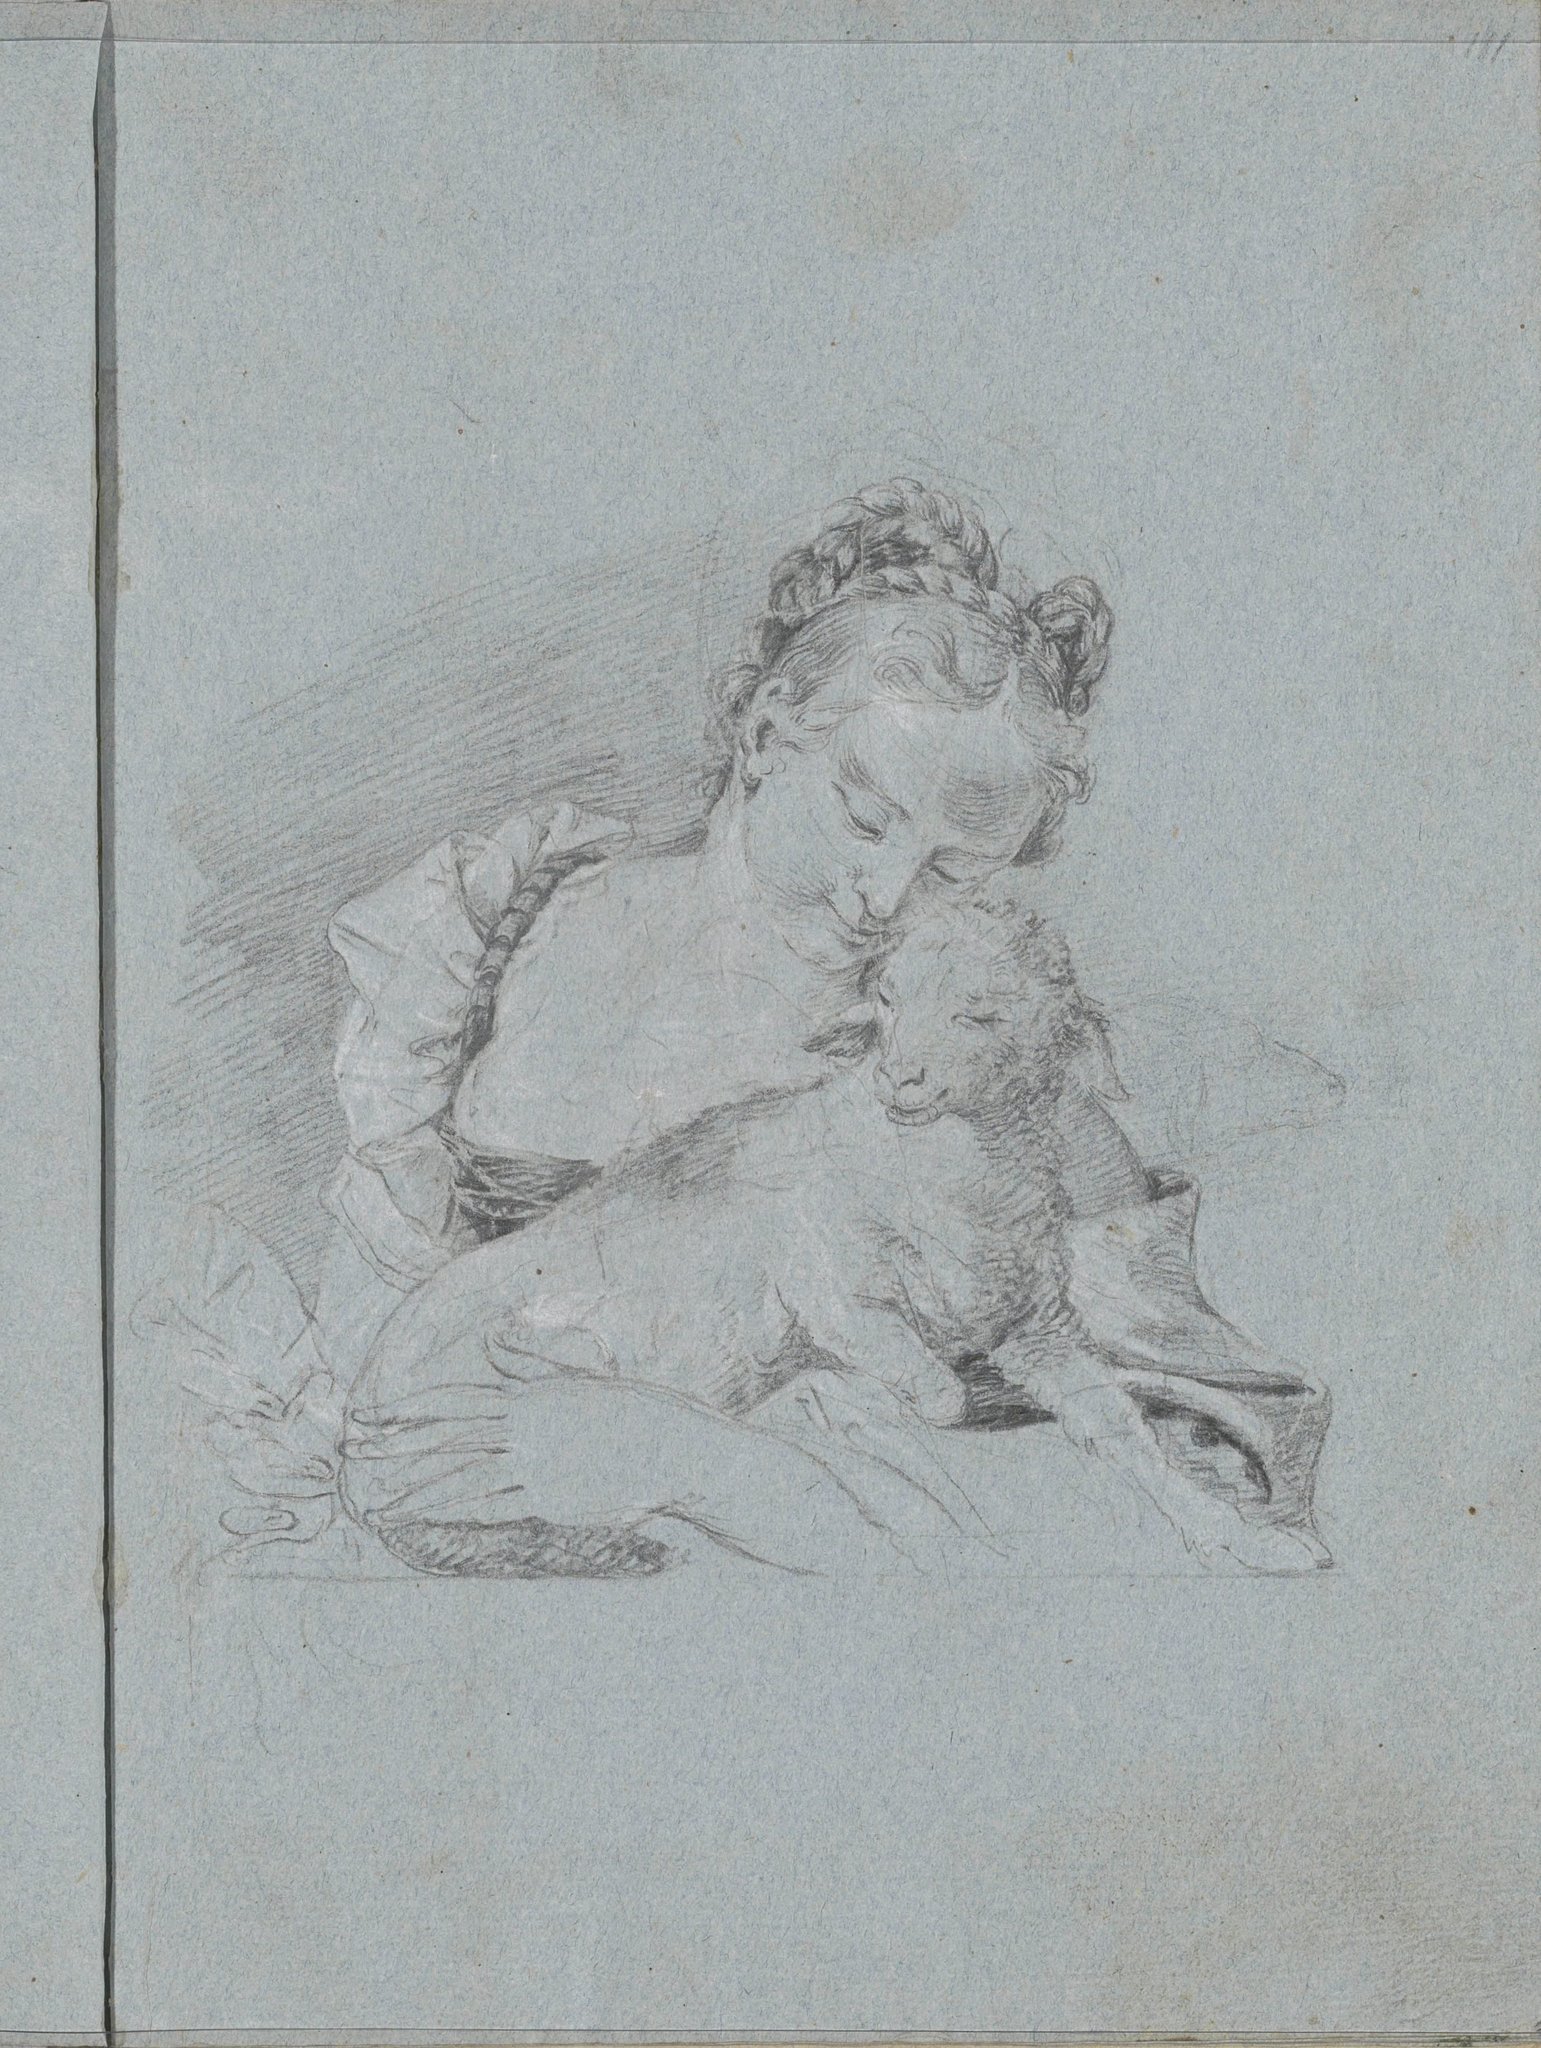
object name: sketchbook leaf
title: Herderin met lam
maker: lorenzo baldissera tiepolo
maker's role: draughtsman, print maker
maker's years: 1736-1776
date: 1751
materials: chalk, paper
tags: herding, herdsman, herdswoman, shepherd, shepherdess, cowherd, etc., lamb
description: Bladzijde 111 uit een schetsboek met 158 bladzijden.